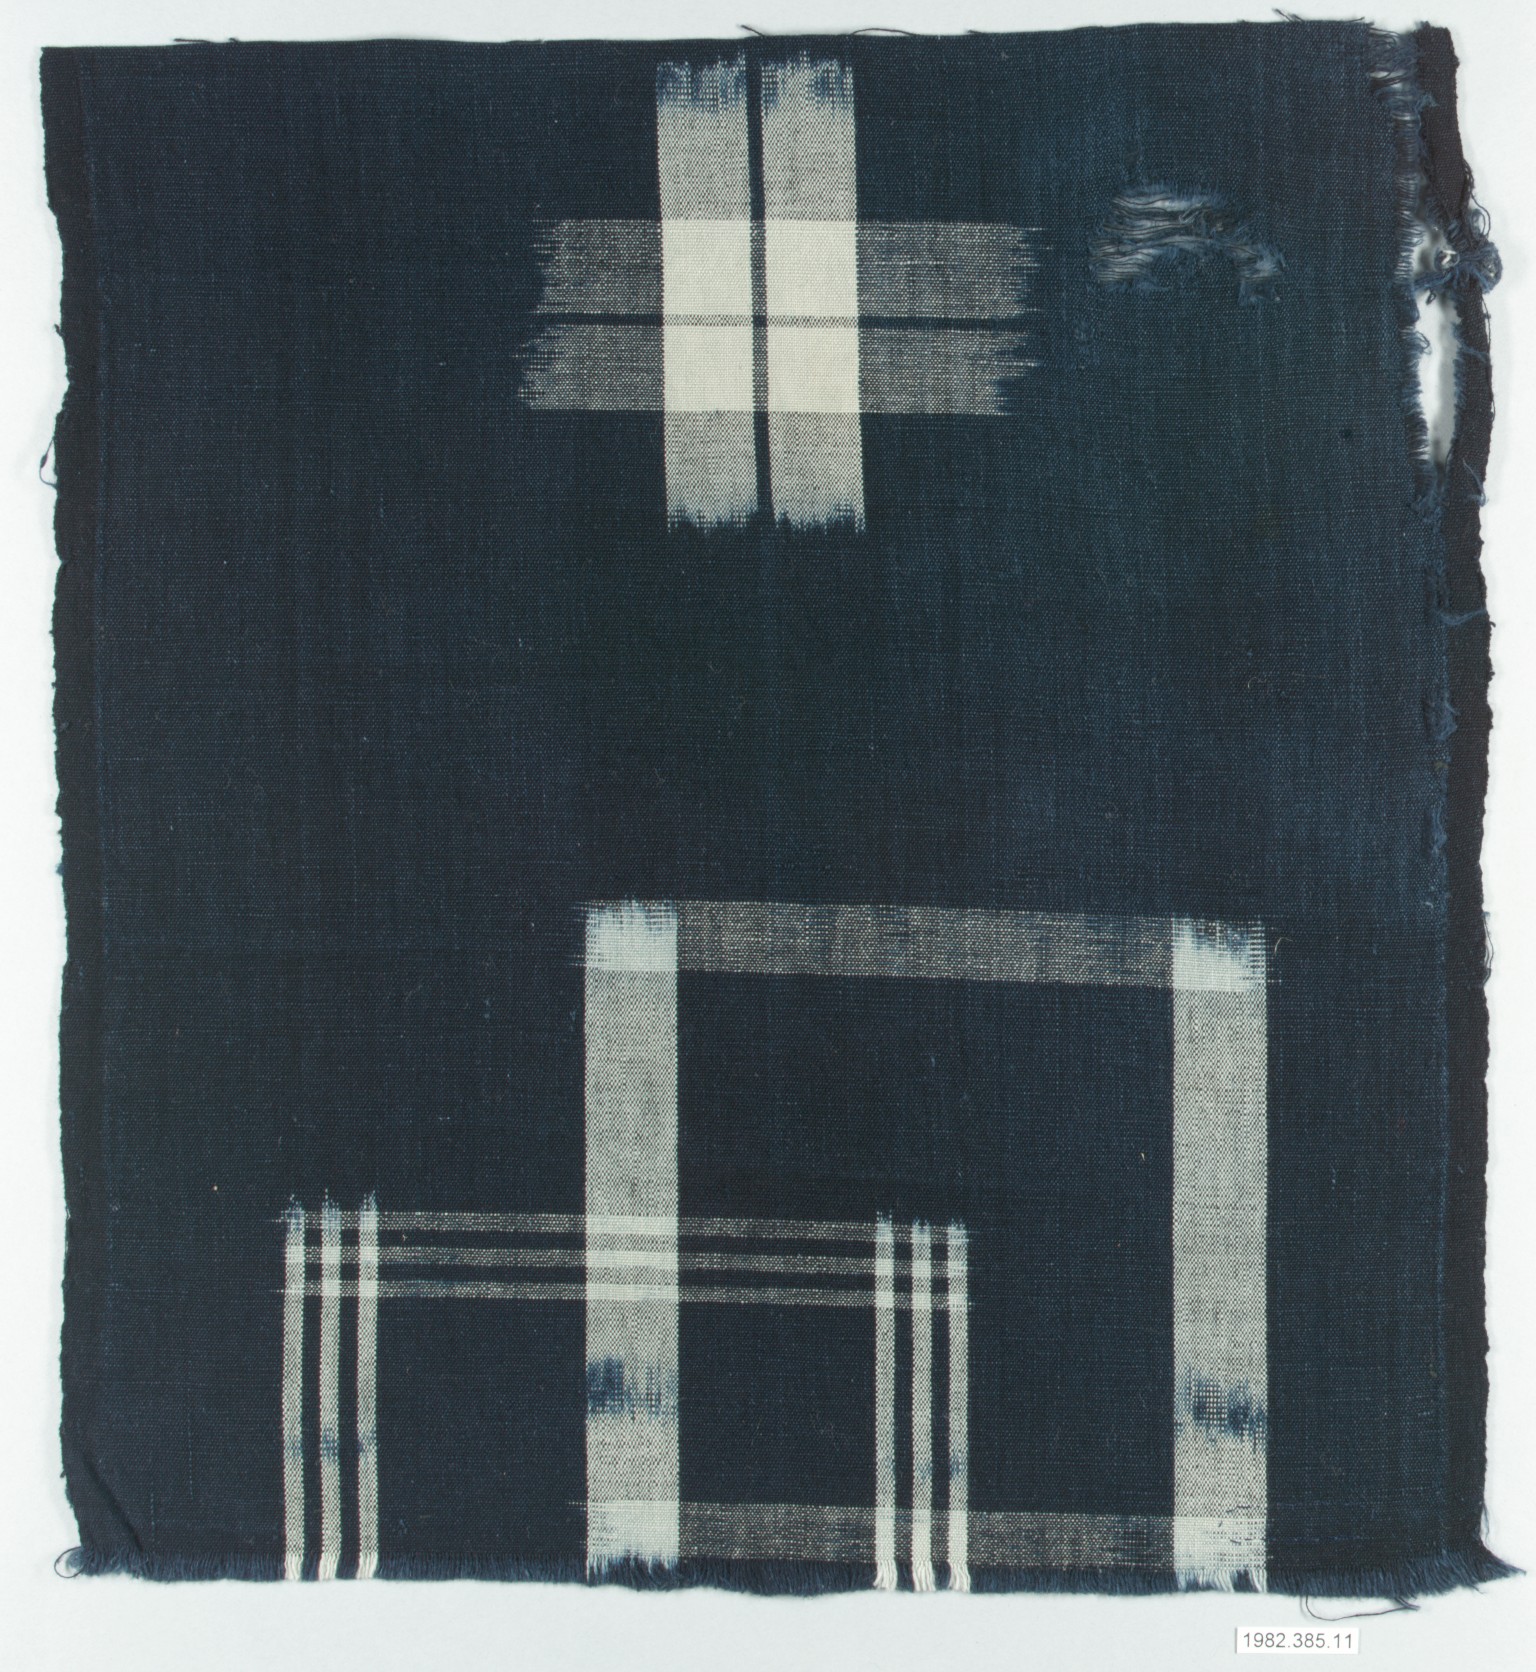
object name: piece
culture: japanese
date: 1868-1926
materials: cotton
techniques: dyeing